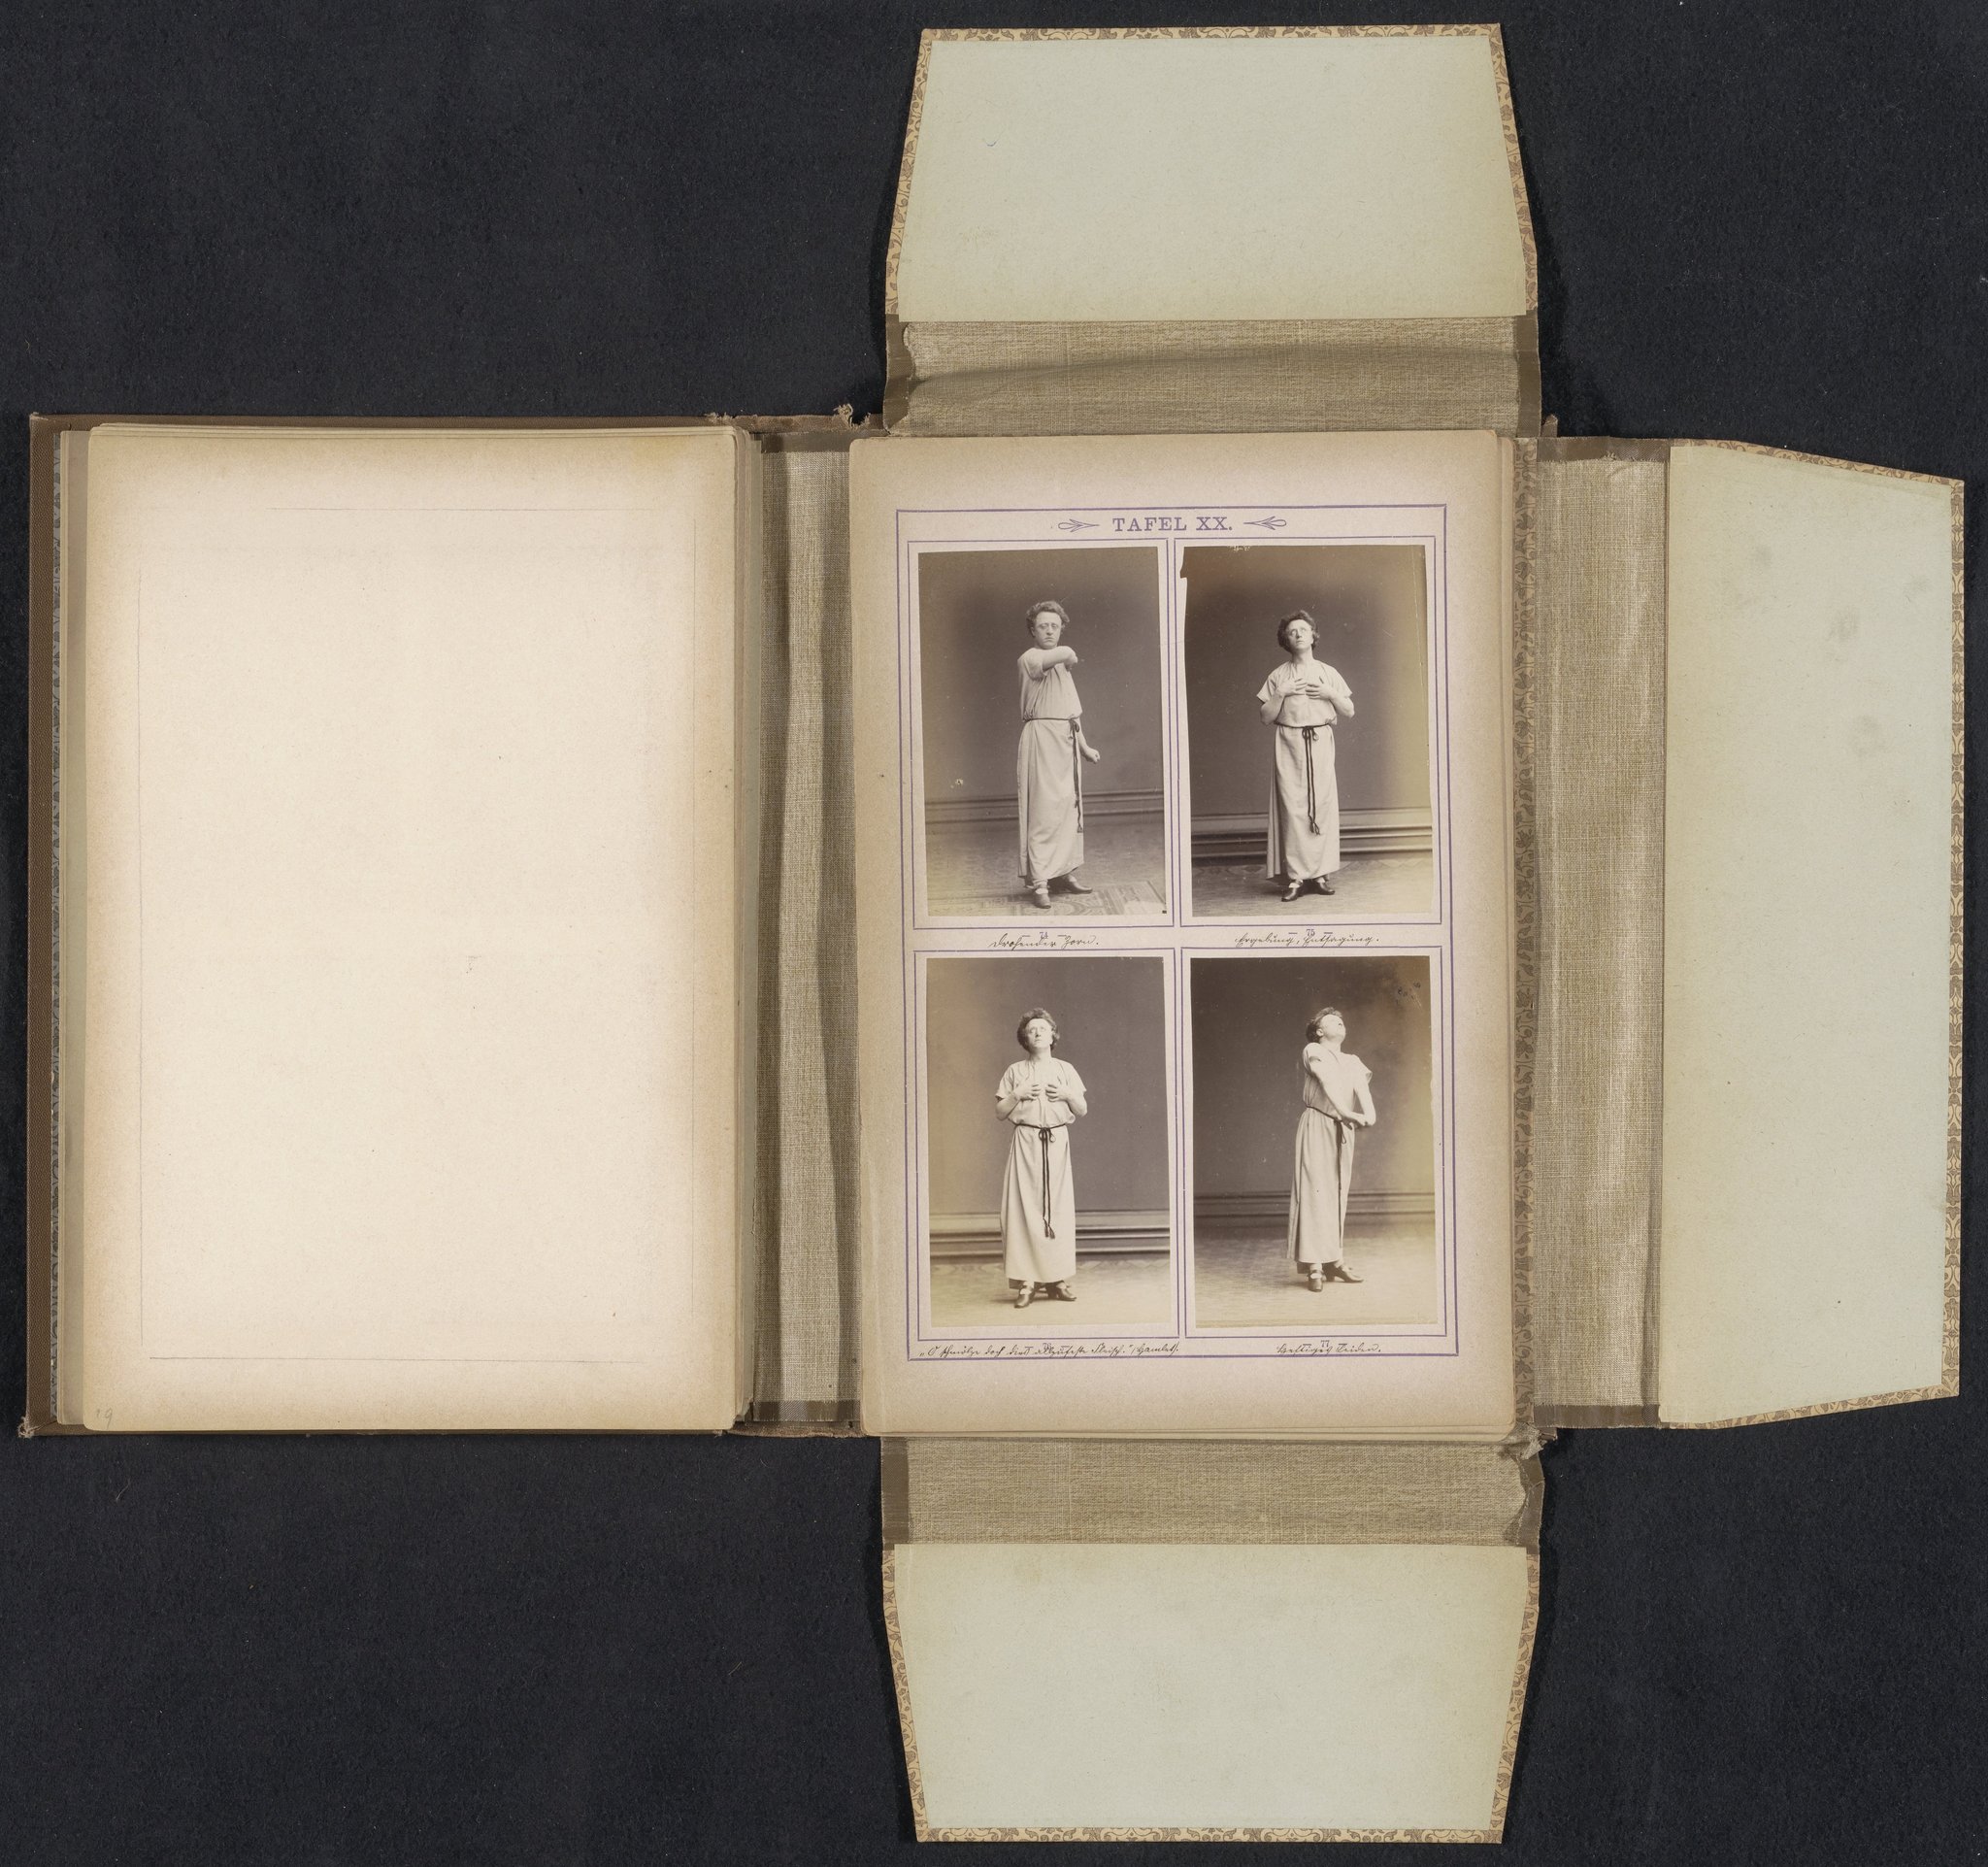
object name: photograph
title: Portretten van een man in vier poses van toorn, vergeving en lijden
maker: nicola tonger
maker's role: fotograaf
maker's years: 1846-1917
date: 1881-1886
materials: cardboard, photographic support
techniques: albumen print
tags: forgivingness, gesture-language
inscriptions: inscription: ‘Drohender (...) Leiden.’, number: ‘Tafel XX.’, number: ‘74 (...) 77.’